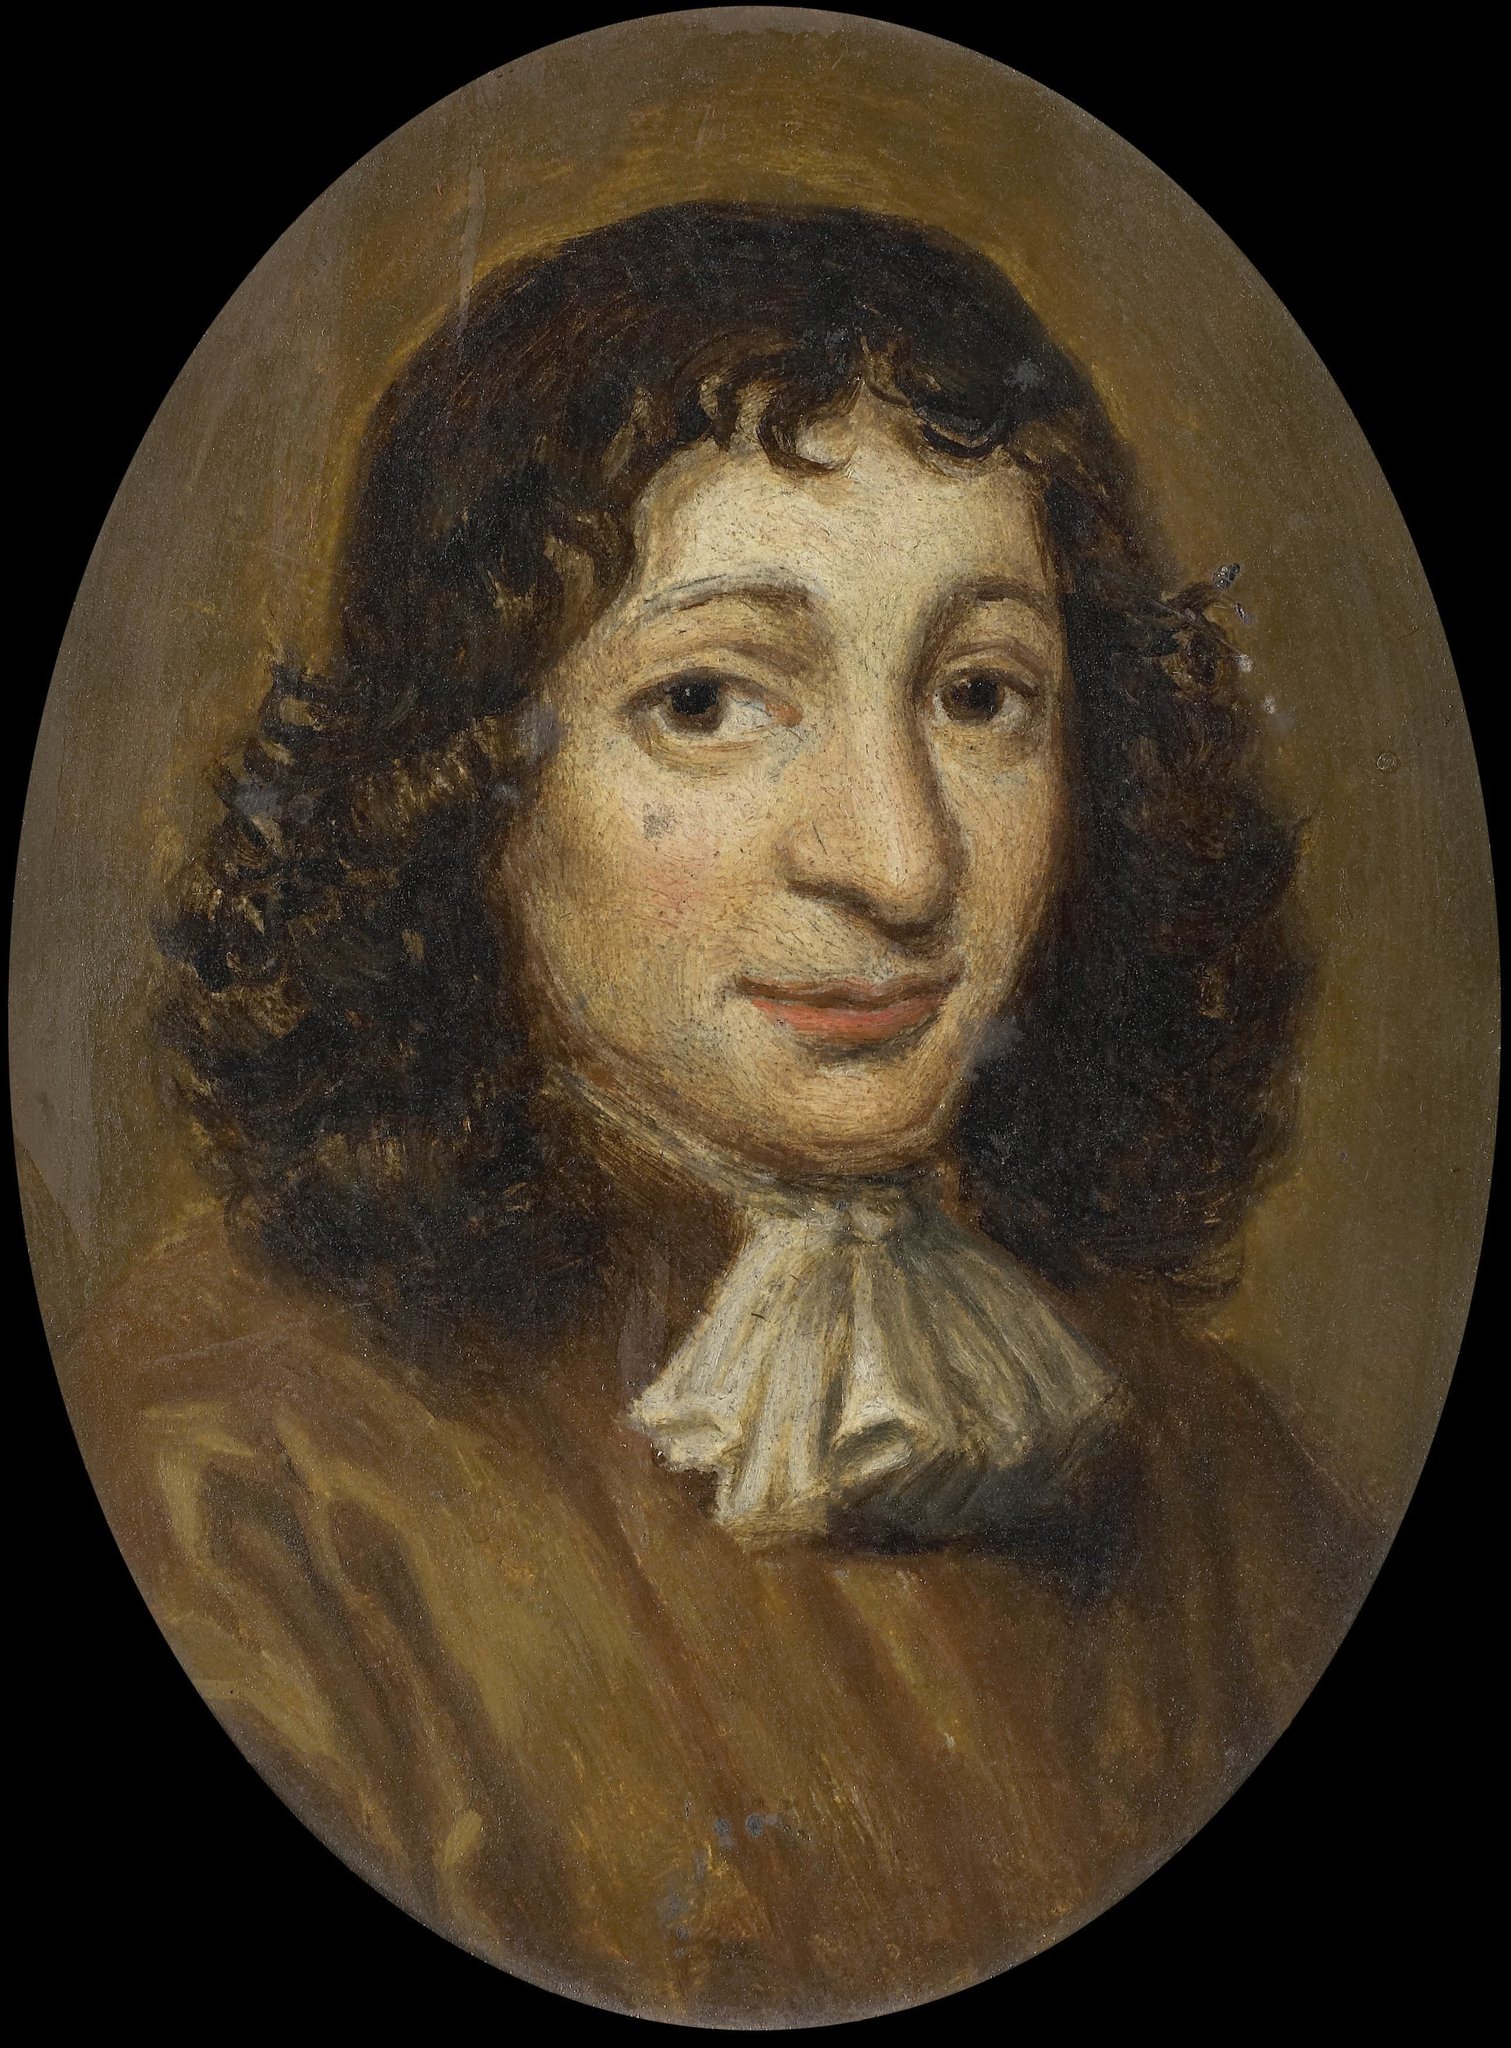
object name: painting, miniature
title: Portret van een man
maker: johan michaël schmidt crans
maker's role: draughtsman, print maker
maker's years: 1830-1907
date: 1840-1907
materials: cardboard, oil, wood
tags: amsterdam, the hague, baruch de spinoza, historical persons not known by name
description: Portret van een man. Buste, naar rechts, aanziend. Vroeger beschouwd als een portret van de filosoof Baruch de Spinoza (1632-77). Naar een miniatuurportret door een onbekende Hollandse meester ca. 1670 in het Koninklijk Huis Archief (cat. nr. 462). Onderdeel van de collectie portretminiaturen.